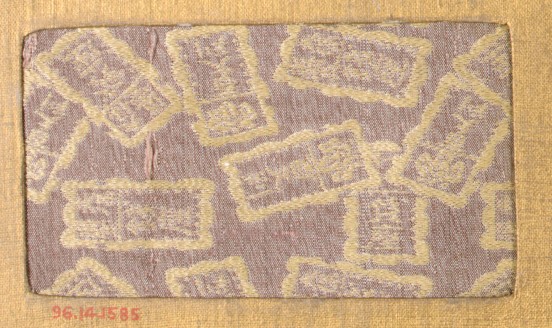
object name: piece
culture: japanese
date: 1701-1900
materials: silk